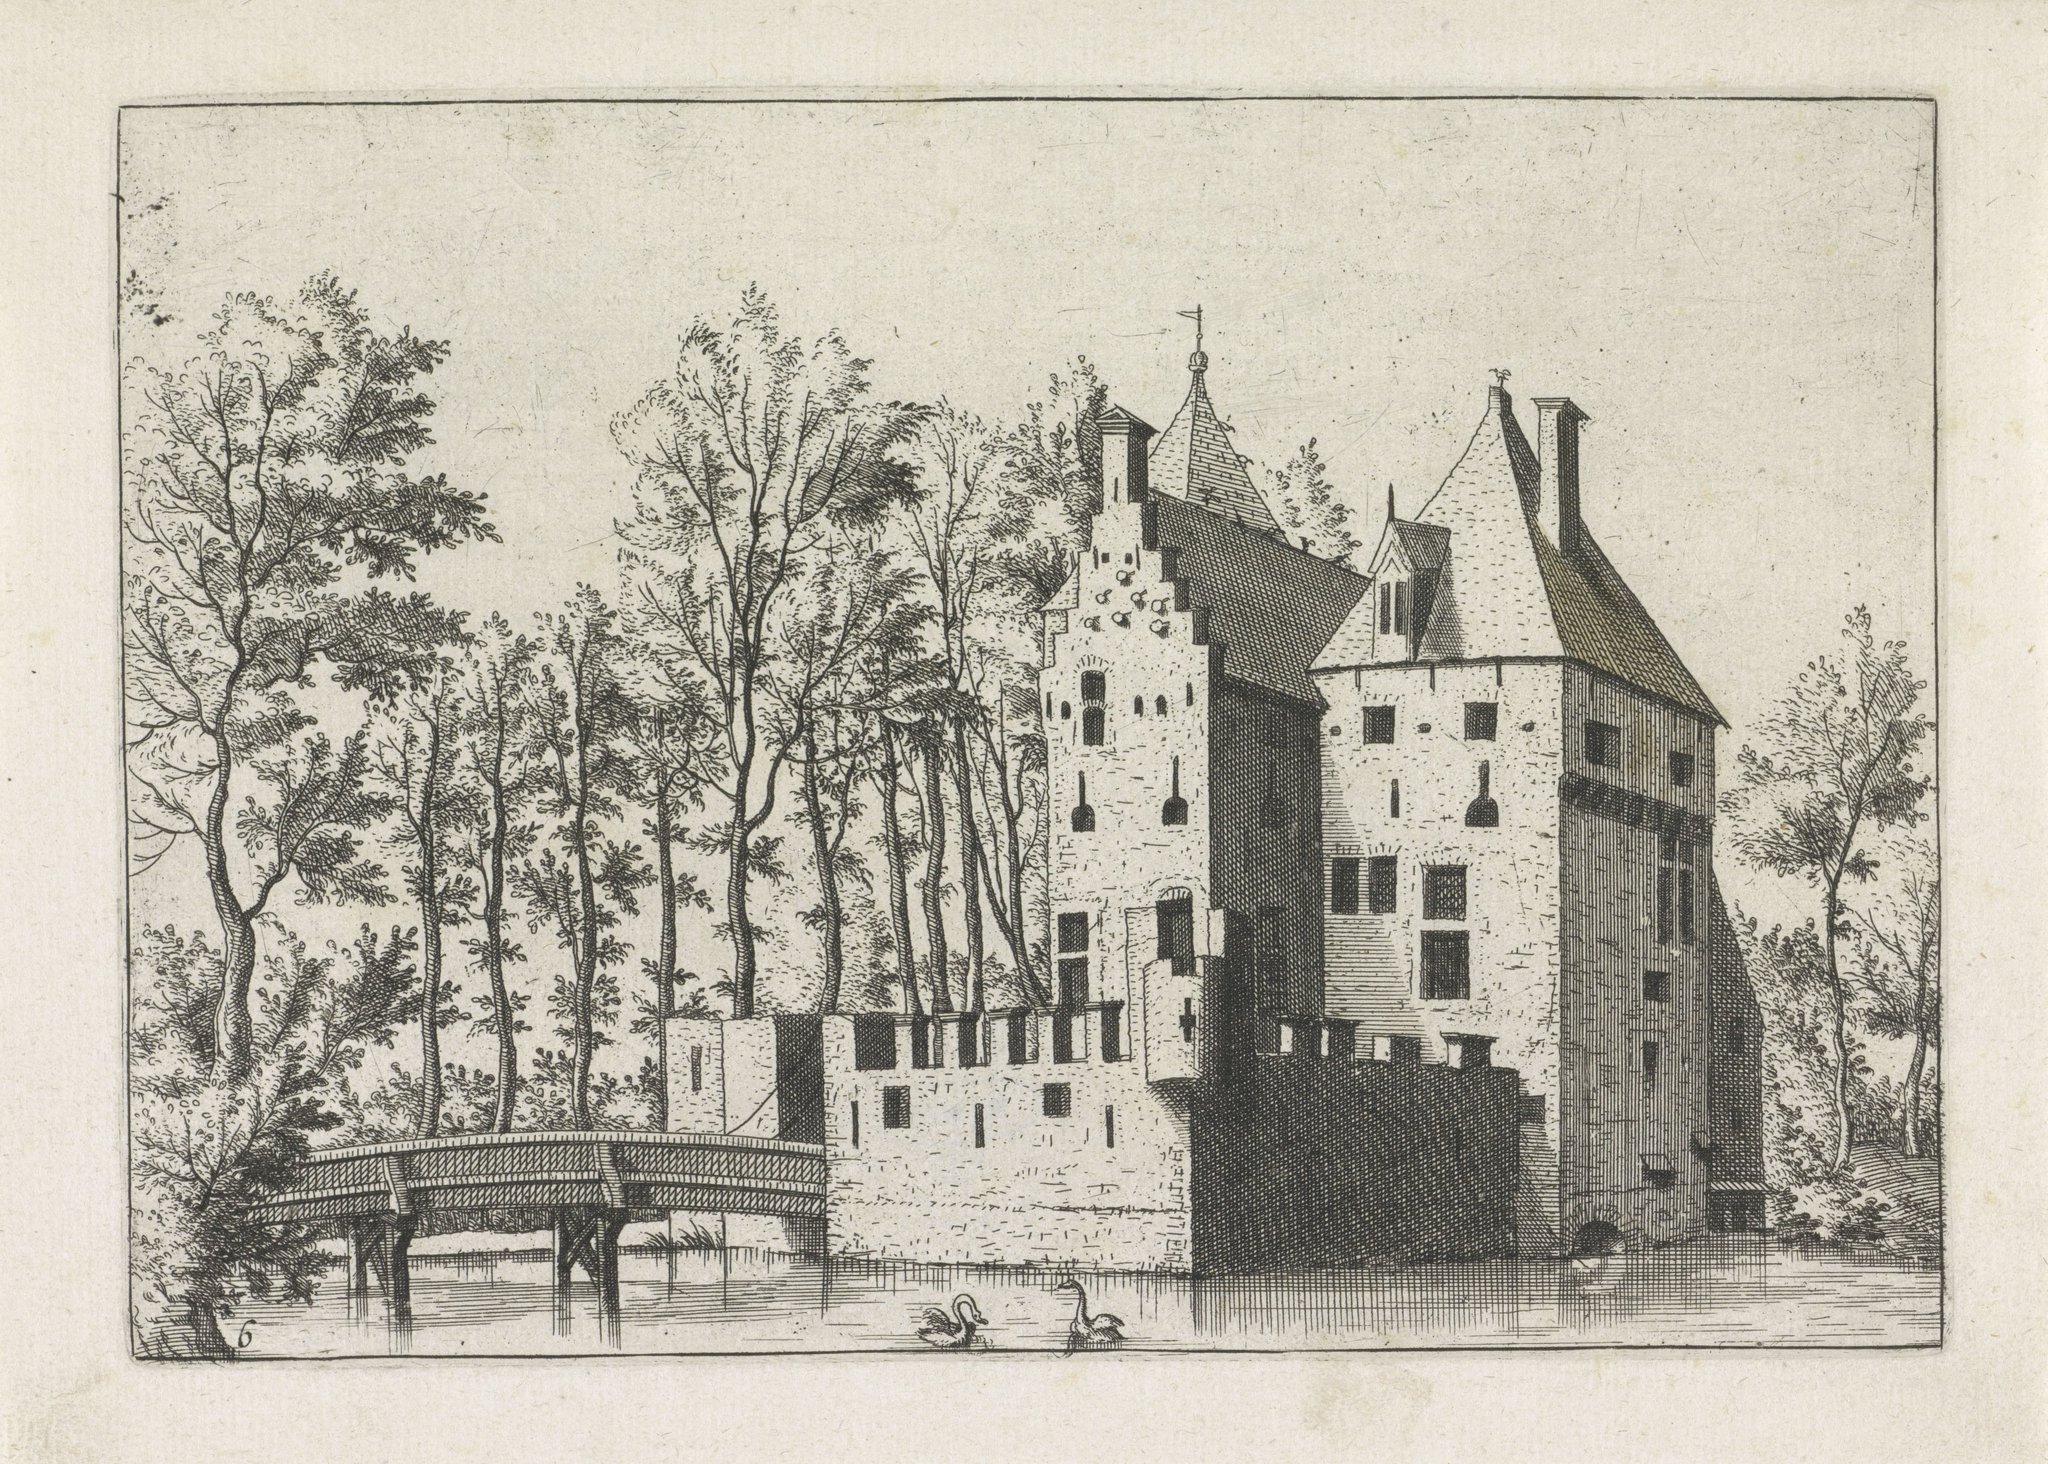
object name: print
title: Kleine landschappen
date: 1559-1561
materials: paper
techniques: etching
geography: antwerp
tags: castle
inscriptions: collector's mark: Lugt 2228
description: Een kasteel met links een ophaalbrug en op de voorgrond in de slotgracht twee zwanen.